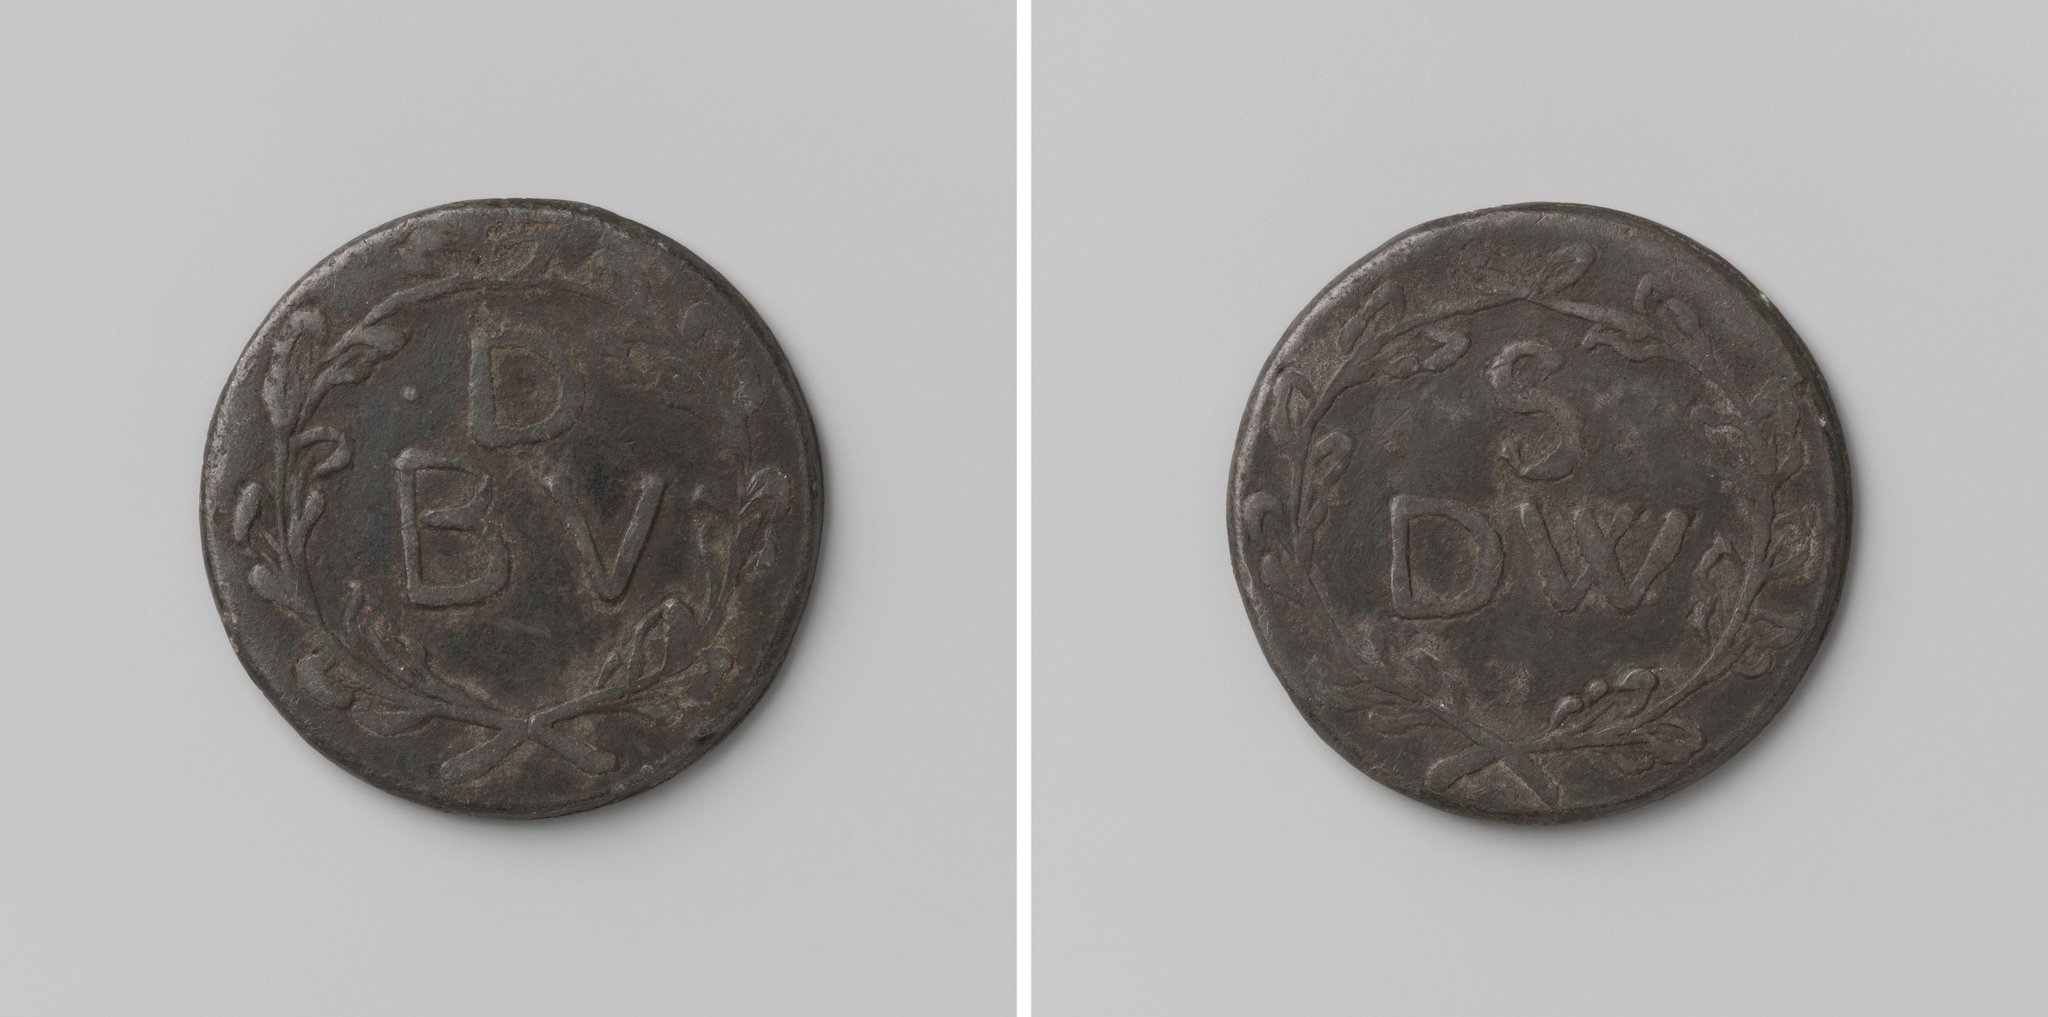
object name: medal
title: Onbekend gilde, gildepenning met monogrammen B.D.V. en D.S.W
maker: Anonymous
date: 1600-1800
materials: lead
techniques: casting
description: Loden penning. Voorzijde: monogram van letters B, D en V in bladerkrans. Keerzijde: monogram van letters D, S en W in bladerkrans. Vermodelijk een gildepenning.